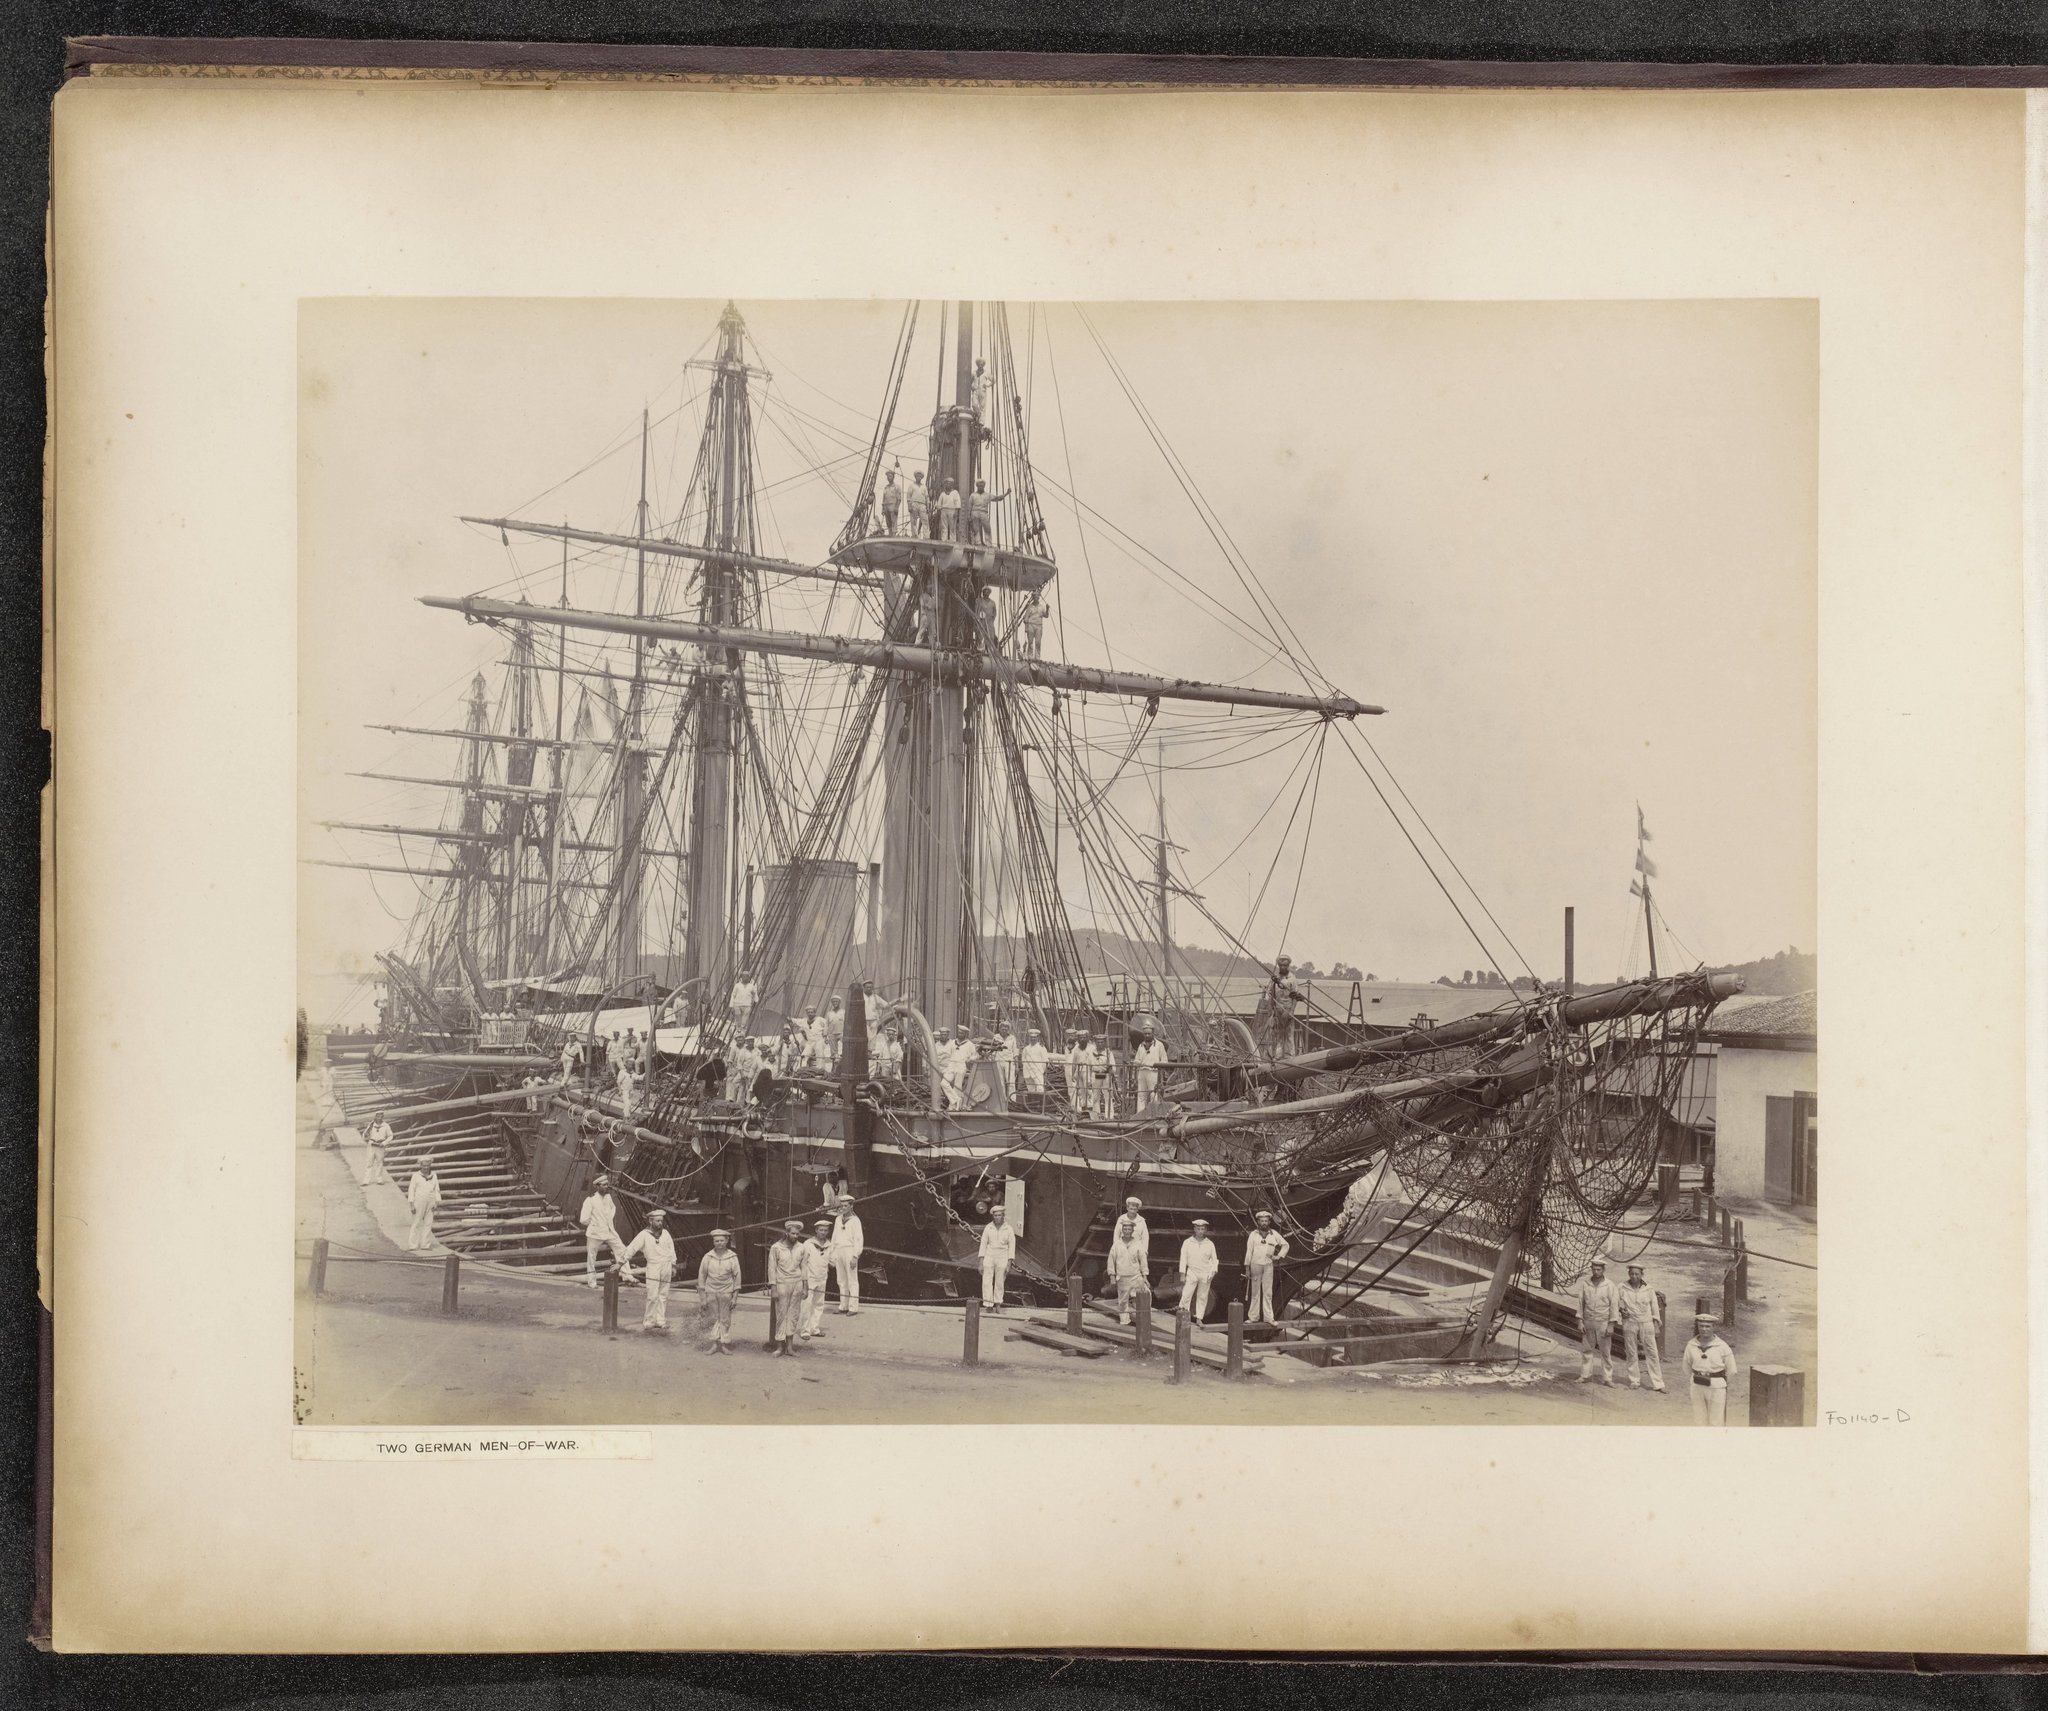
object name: photograph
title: Two German men-of-war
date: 1890-1905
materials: photographic support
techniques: albumen print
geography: singapore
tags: sailing-ship, sailing-boat (with name), dry-dock, floating-dock, pier, quay, wharf, shipyard, shipdock, seaman: sailor, shipbuilding industry, singapore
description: Onderdeel van Fotoalbum van de Tanjong Pagar Dock Co. Ltd. in Singapore.